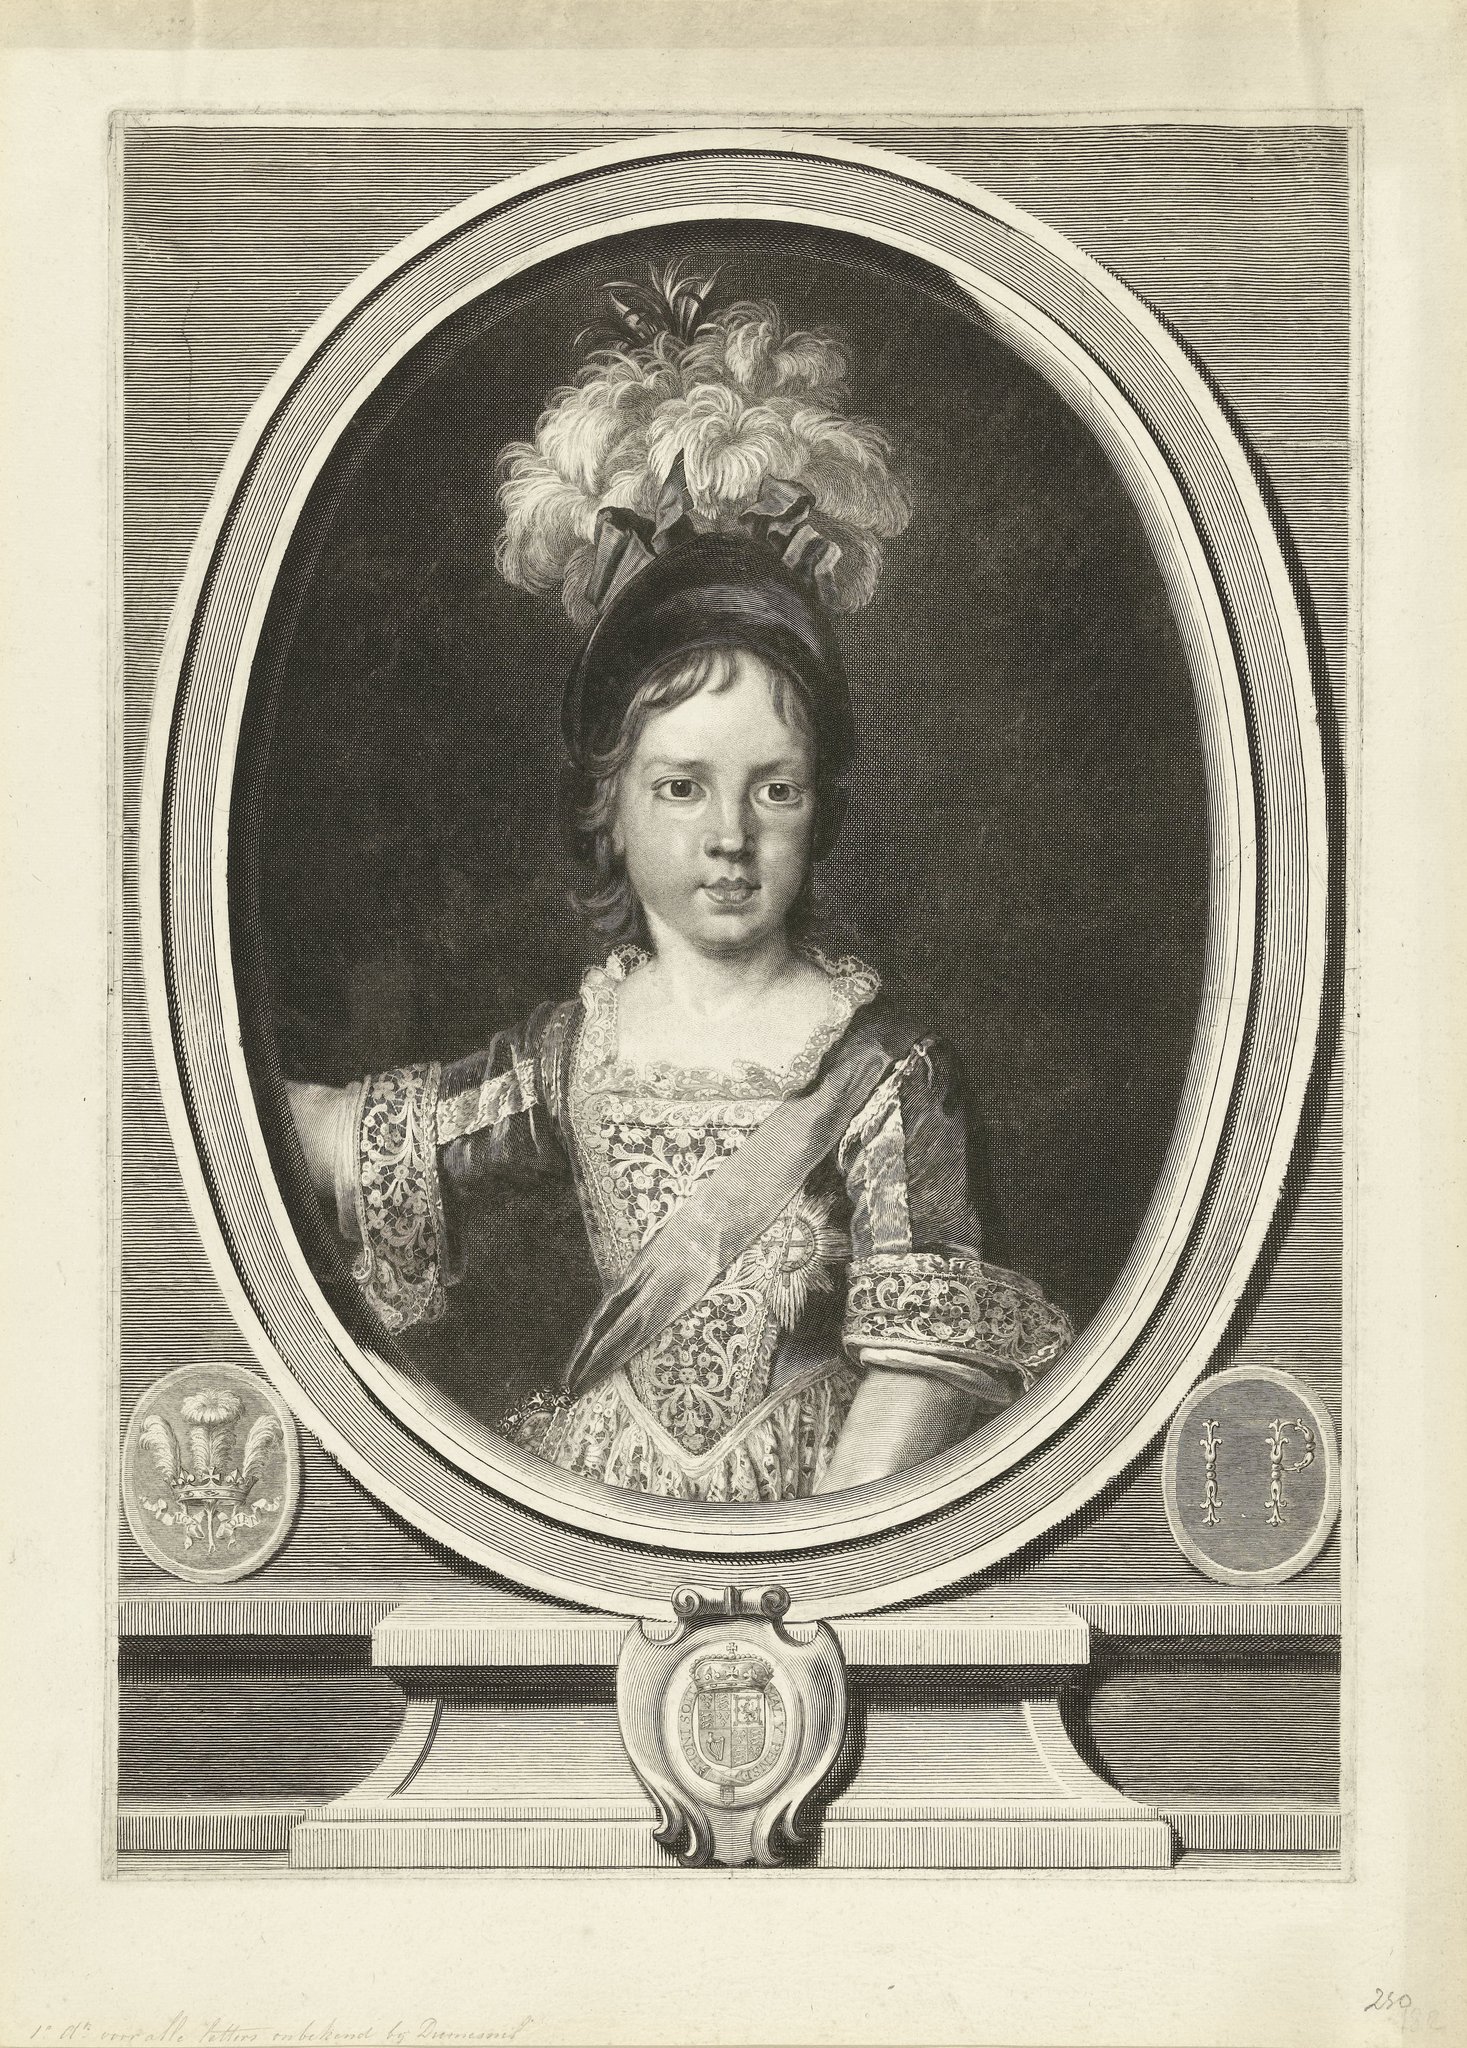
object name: print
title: Portret van Jacobus Frans Eduard Stuart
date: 1692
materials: paper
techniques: engraving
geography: france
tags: london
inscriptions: collector's mark: Lugt 240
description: Portret van de jonge Jacobus Frans Eduard Stuart (1688-1766), prins van Wales, ook wel bekend als The Old Pretender. Afgebeeld in hofkleding met hoofdtooi, in een ovale omlijsting met drie wapens.